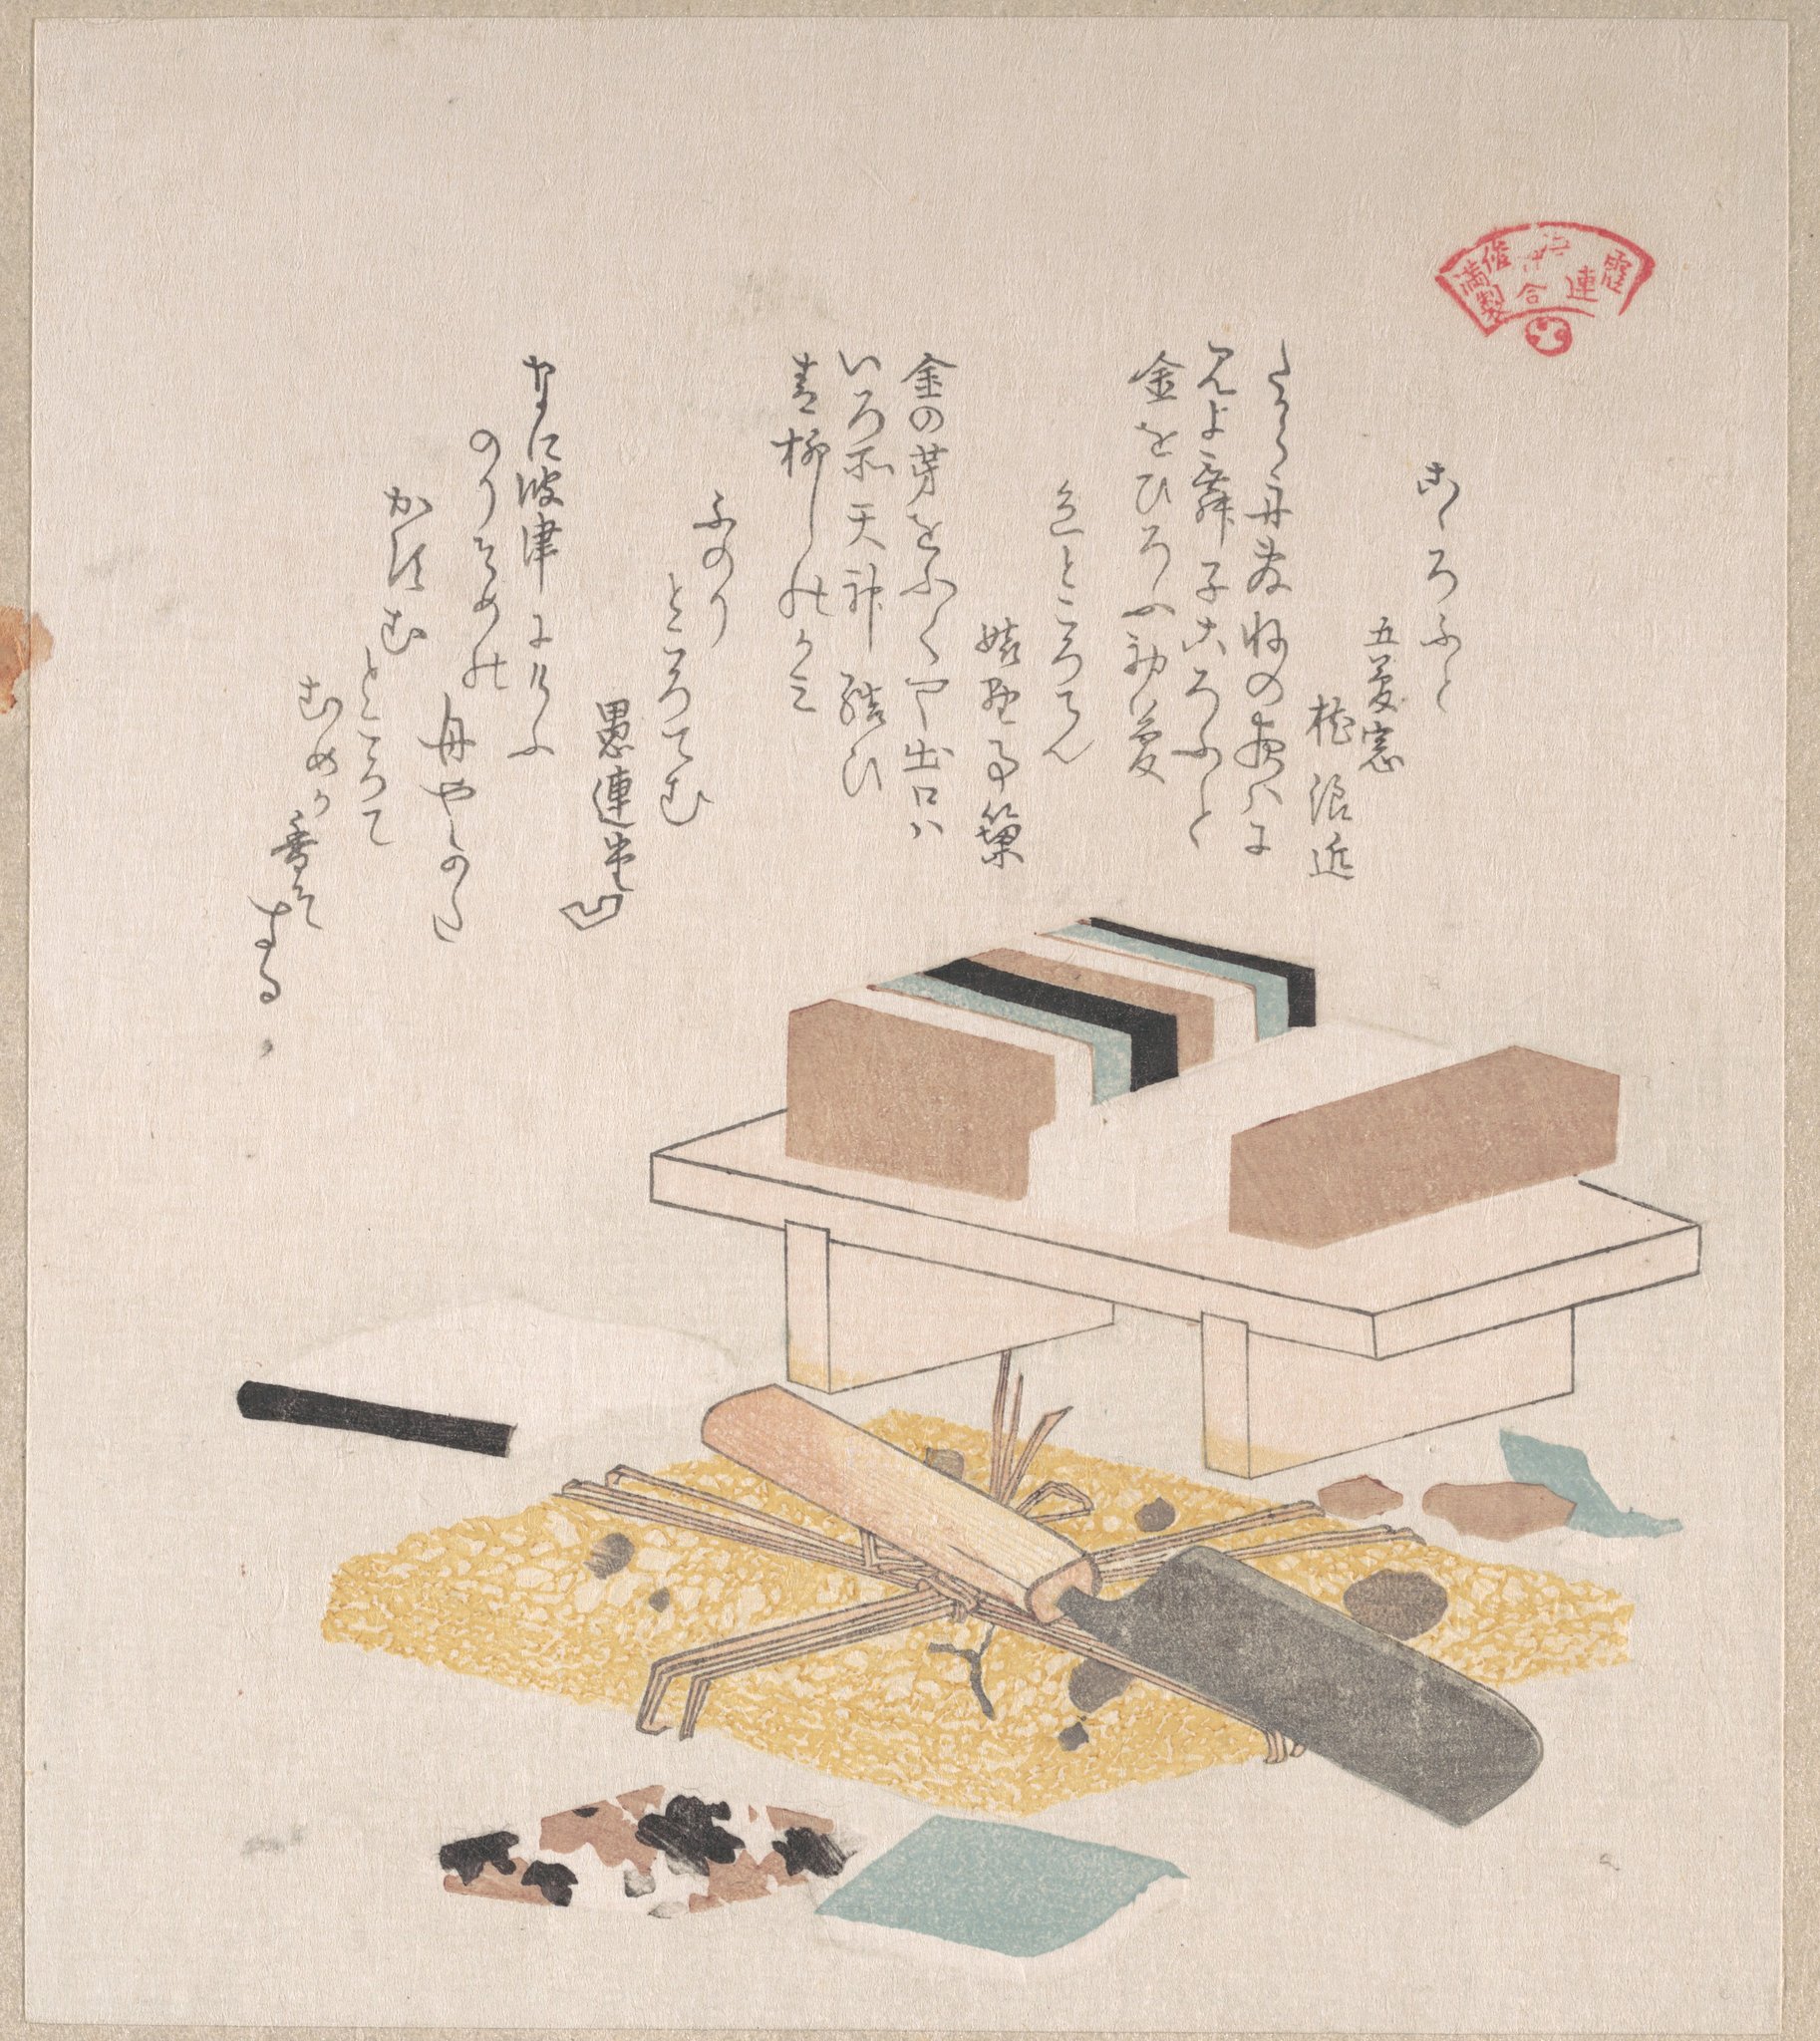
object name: print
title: Seaweed Food and Kitchen Utensils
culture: japanese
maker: kubo shunman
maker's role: artist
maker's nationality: japanese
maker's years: 1757-1820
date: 1801-1900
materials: ink, paper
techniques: surimono, woodblock print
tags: food,knives